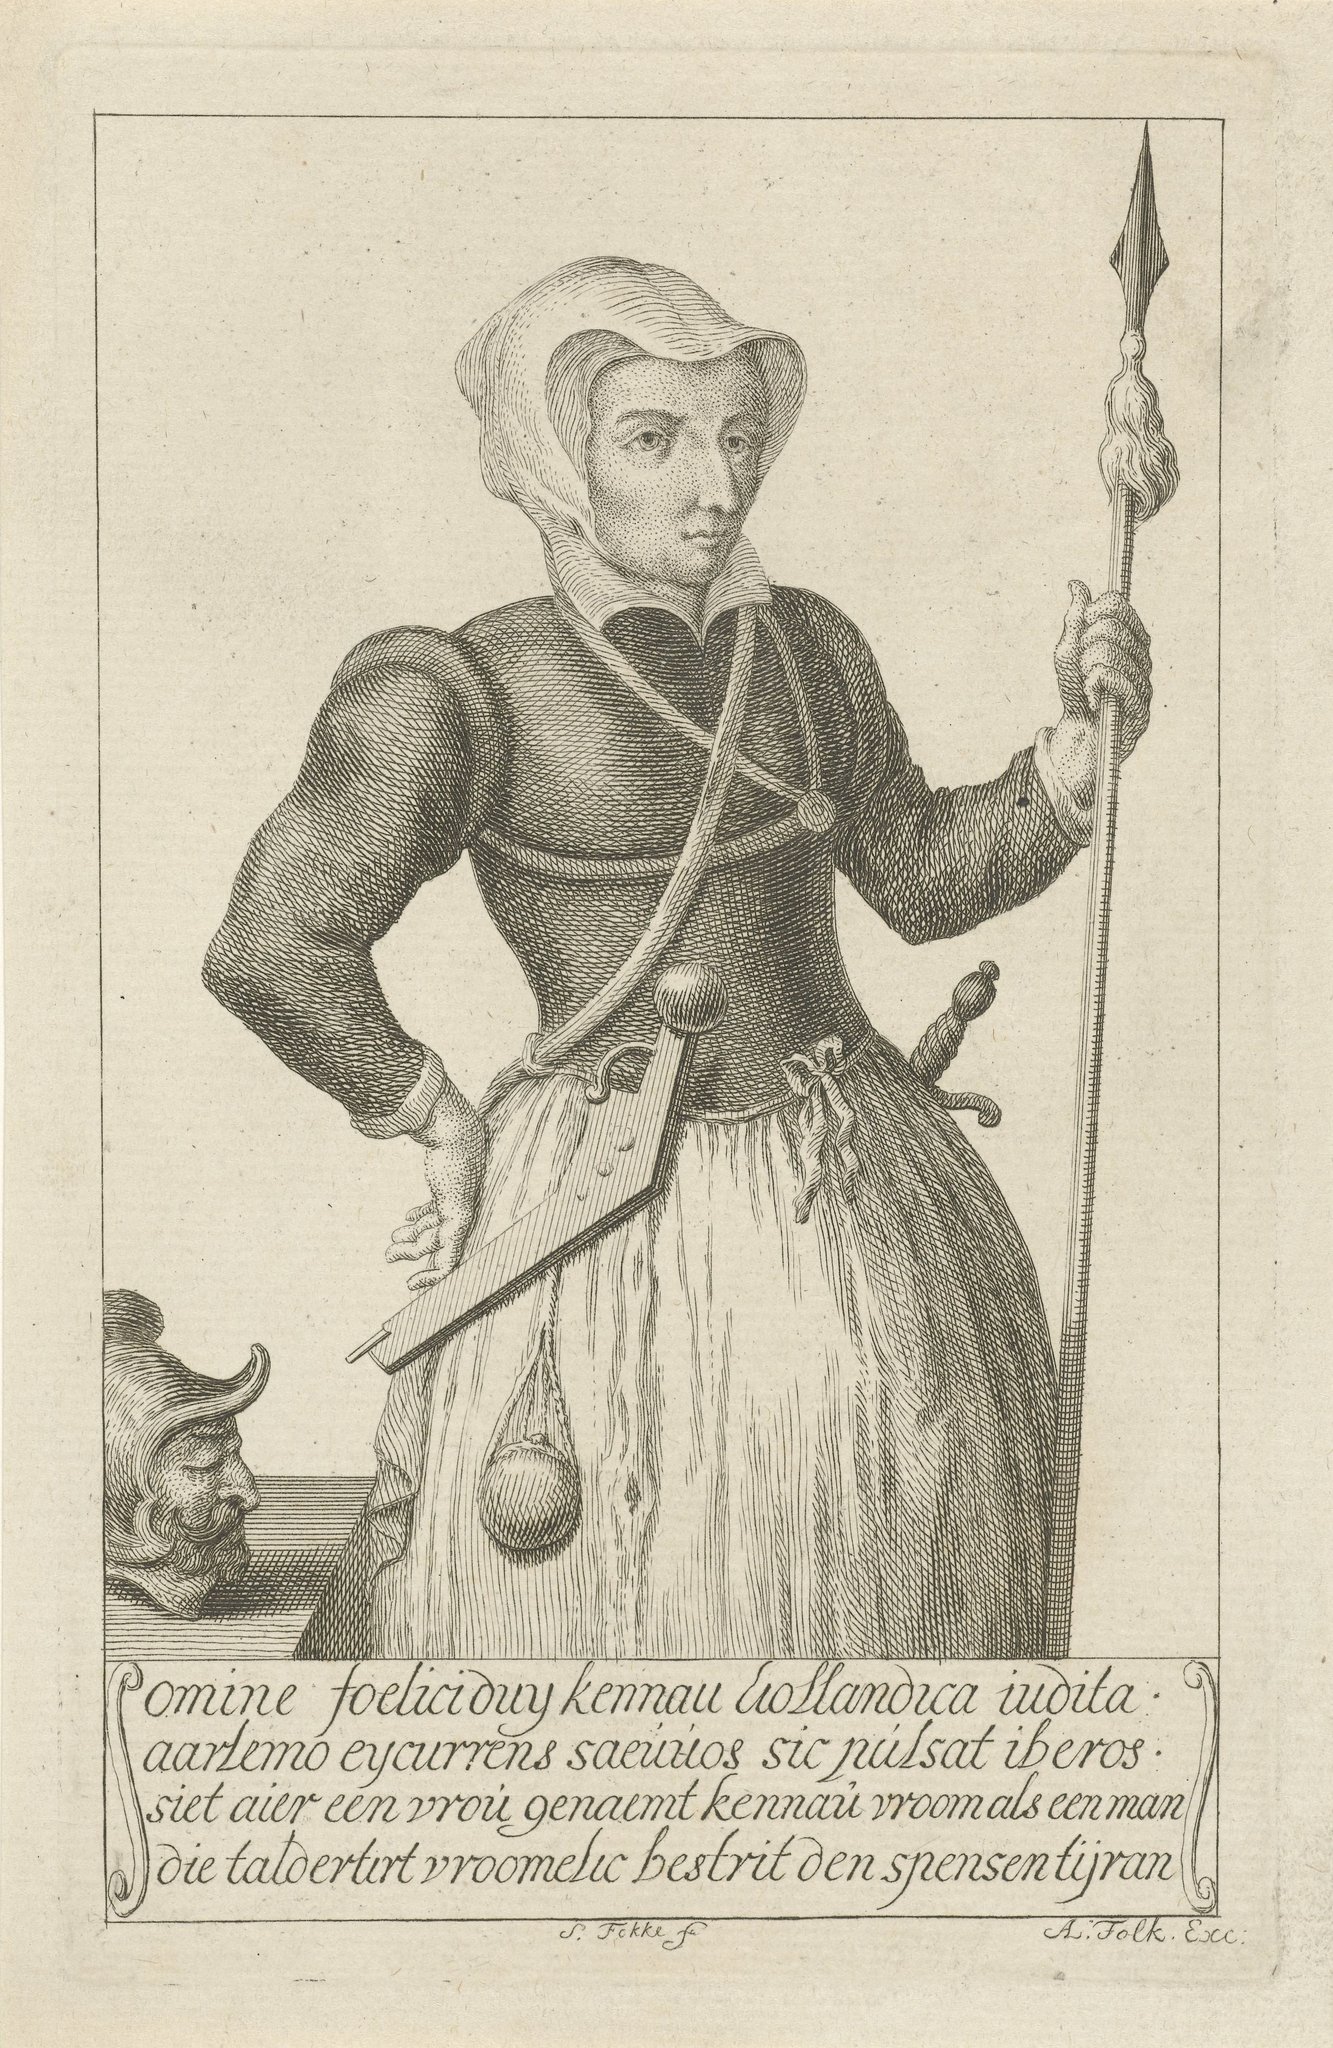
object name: print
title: Portret van Kenau Simonsdochter Hasselaar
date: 1722-1784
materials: paper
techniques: engraving, etching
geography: amsterdam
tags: historical persons - bb - woman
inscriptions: collector's mark: Lugt 2228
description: Portret ter halver lijve, naar rechts, van Kenau Simonsdochter Hasselaar. In haar rechterhand draagt ze een speer. Links het blad van een tafel waarop het hoofd van een Spanjaard ligt. Onder de afbeelding staat een vierregelige tekst.